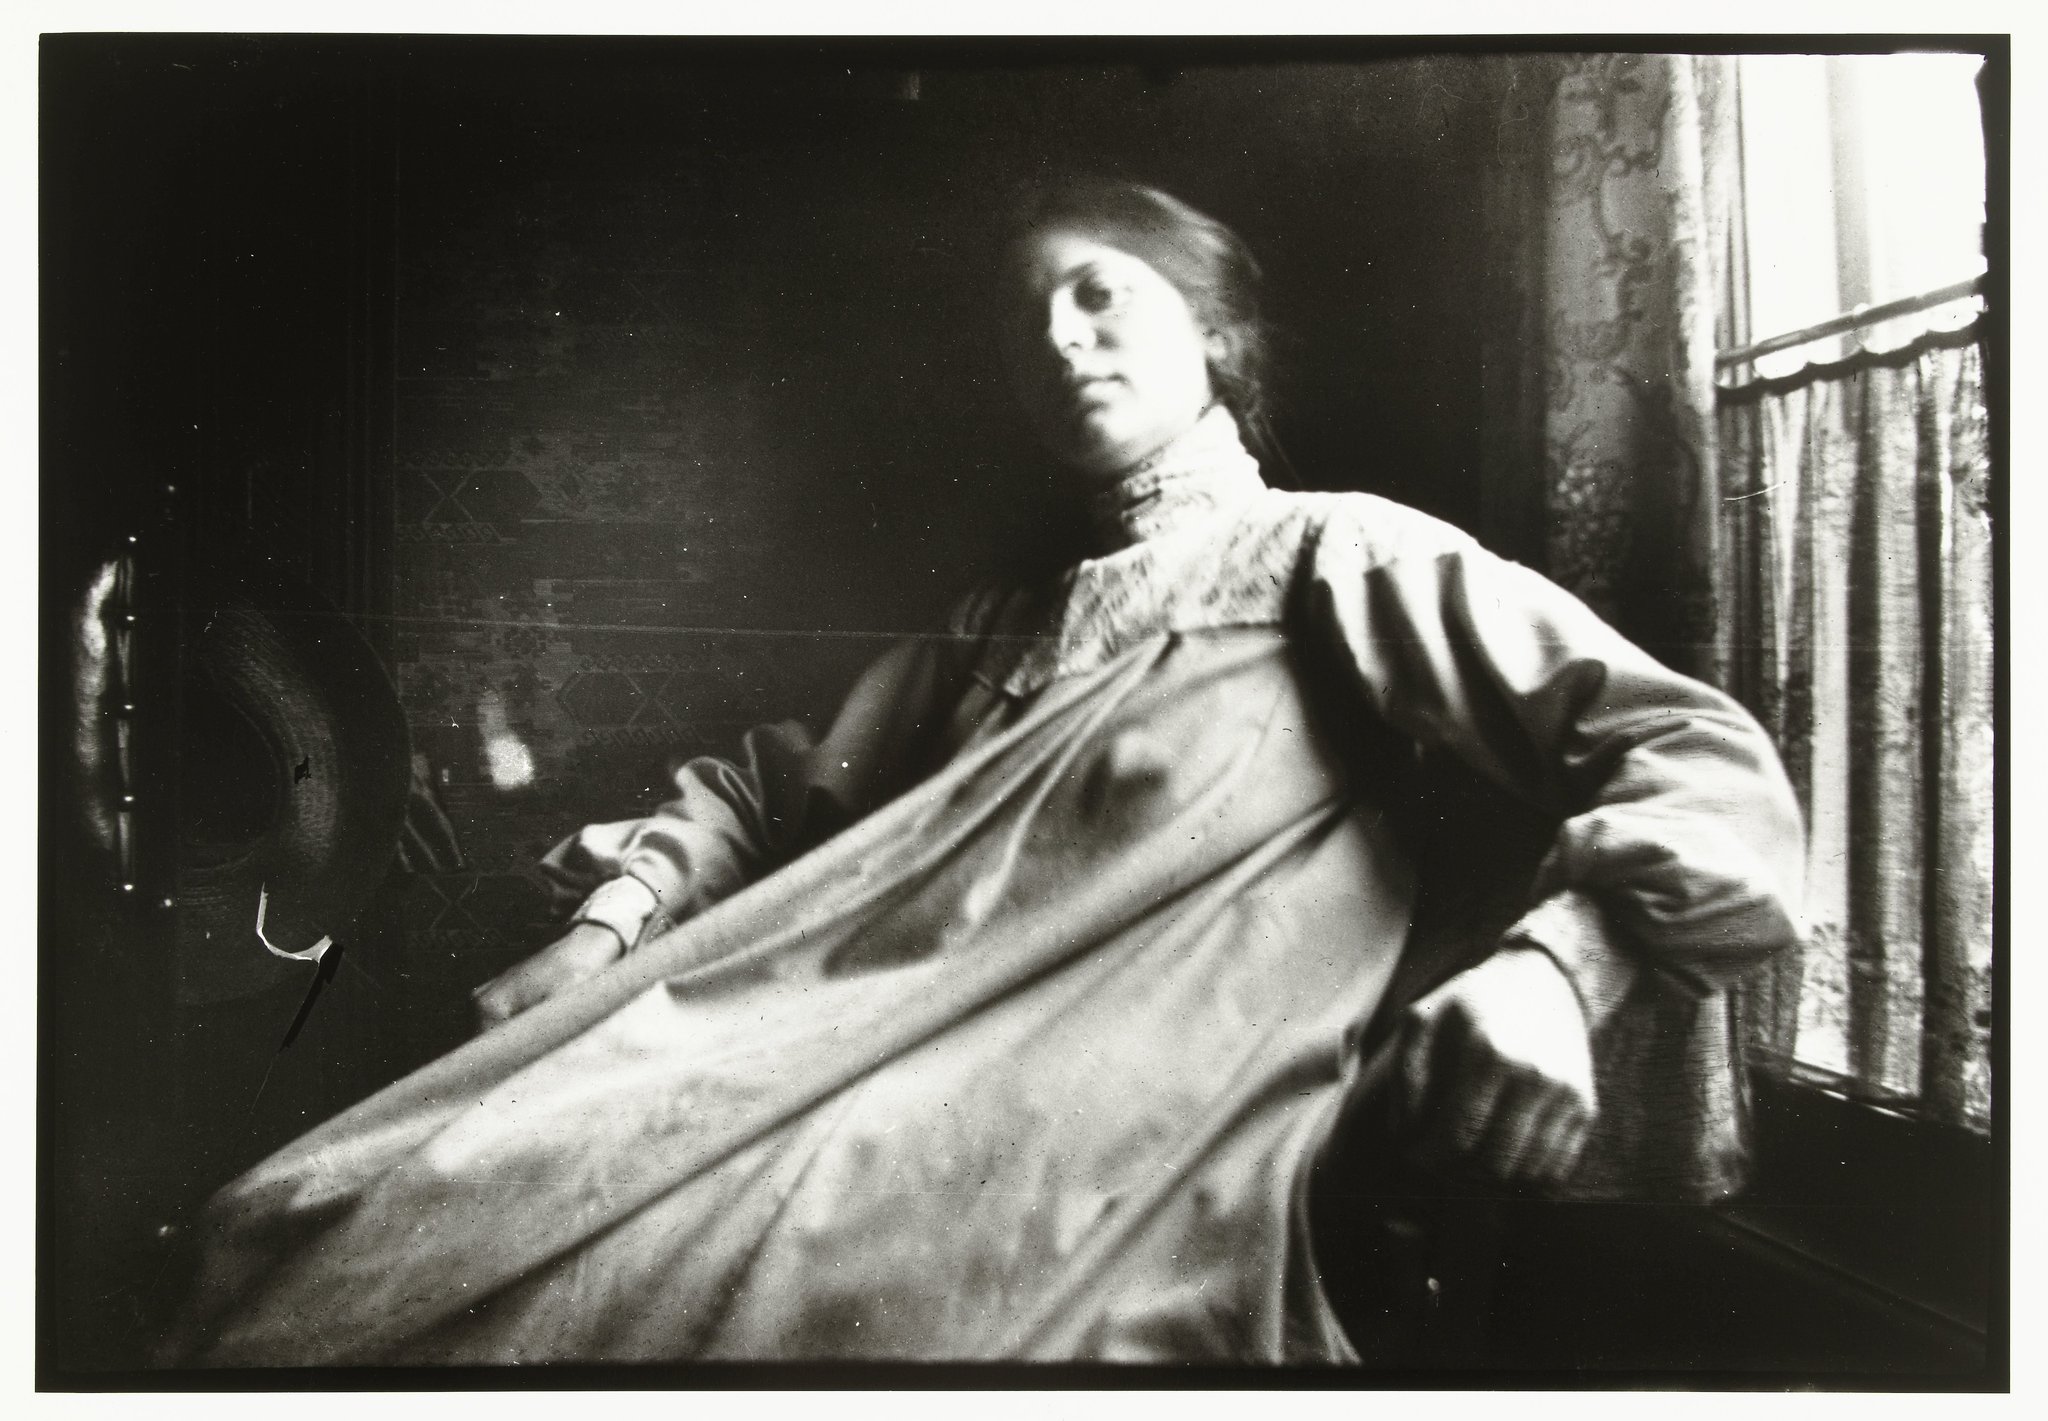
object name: photograph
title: Portret van een onbekende vrouw bij Breitner thuis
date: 1890-1910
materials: paper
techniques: gelatin silver print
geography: amsterdam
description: Moderne afdruk van negatief BR 789 (collectie RKD).